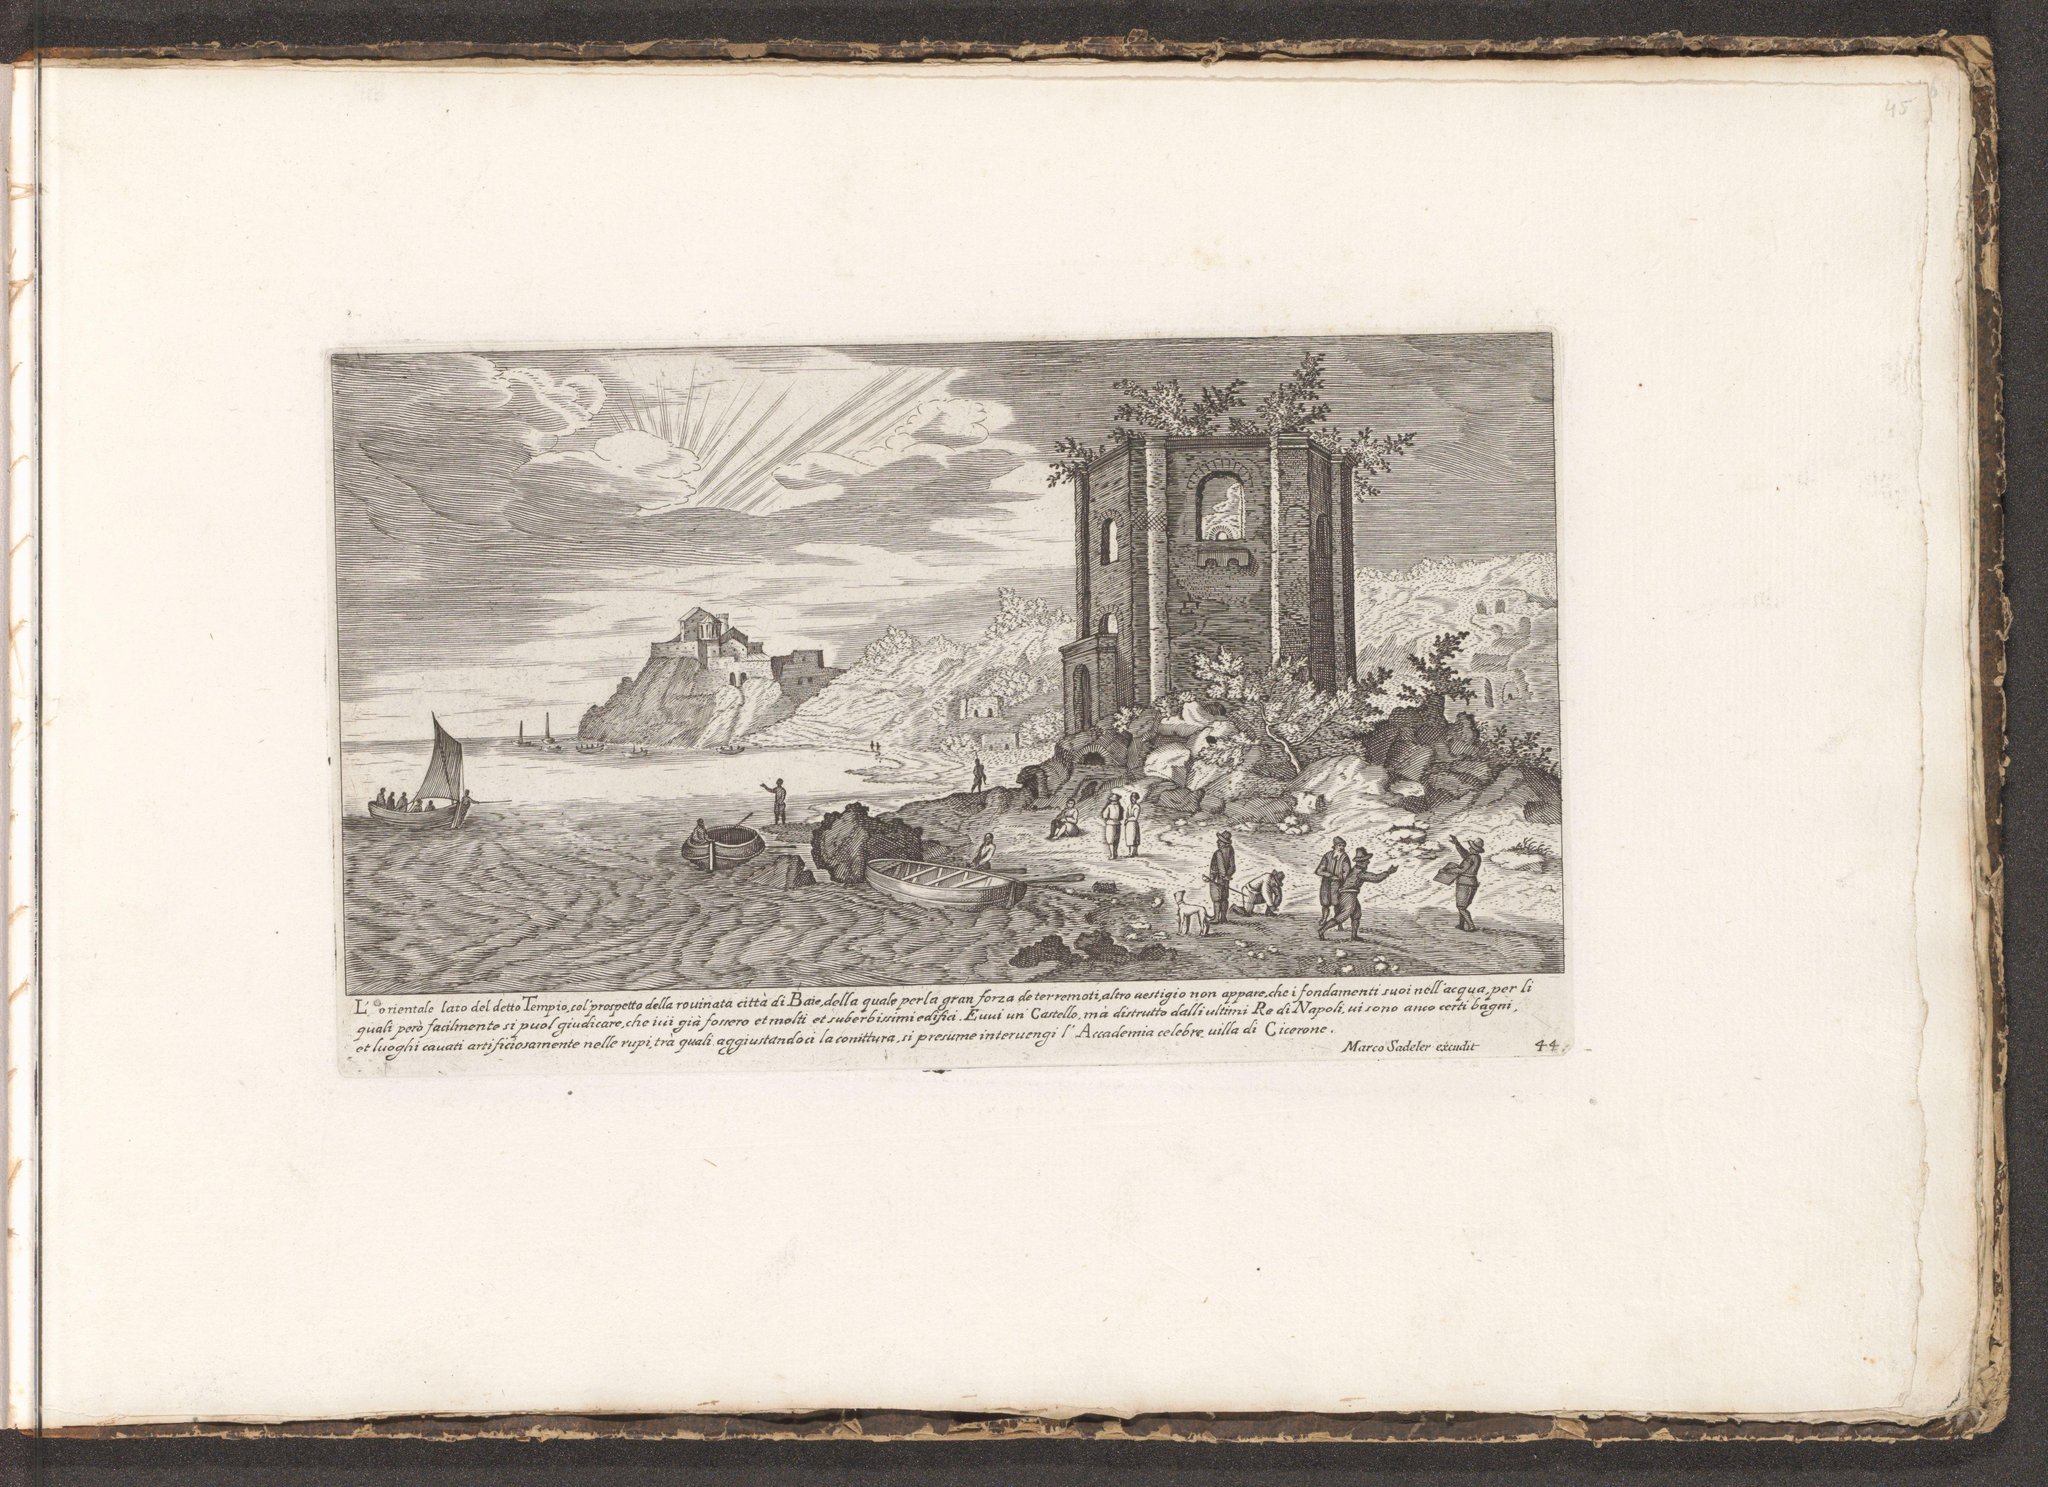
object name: album leaf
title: Vestigi delle antichita di Roma, Tivoli, Pozzuolo et altri luochi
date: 1680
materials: paper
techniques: engraving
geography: prague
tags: baia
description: De overblijfselen van de tempel van Venus bij Baia, gezien vanuit het oosten. De ruïne ligt aan de kust. Met boten en figuren op de voorgrond. In de ondermarge drie regels tekst in het Italiaans. De prent maakt deel uit van een album.